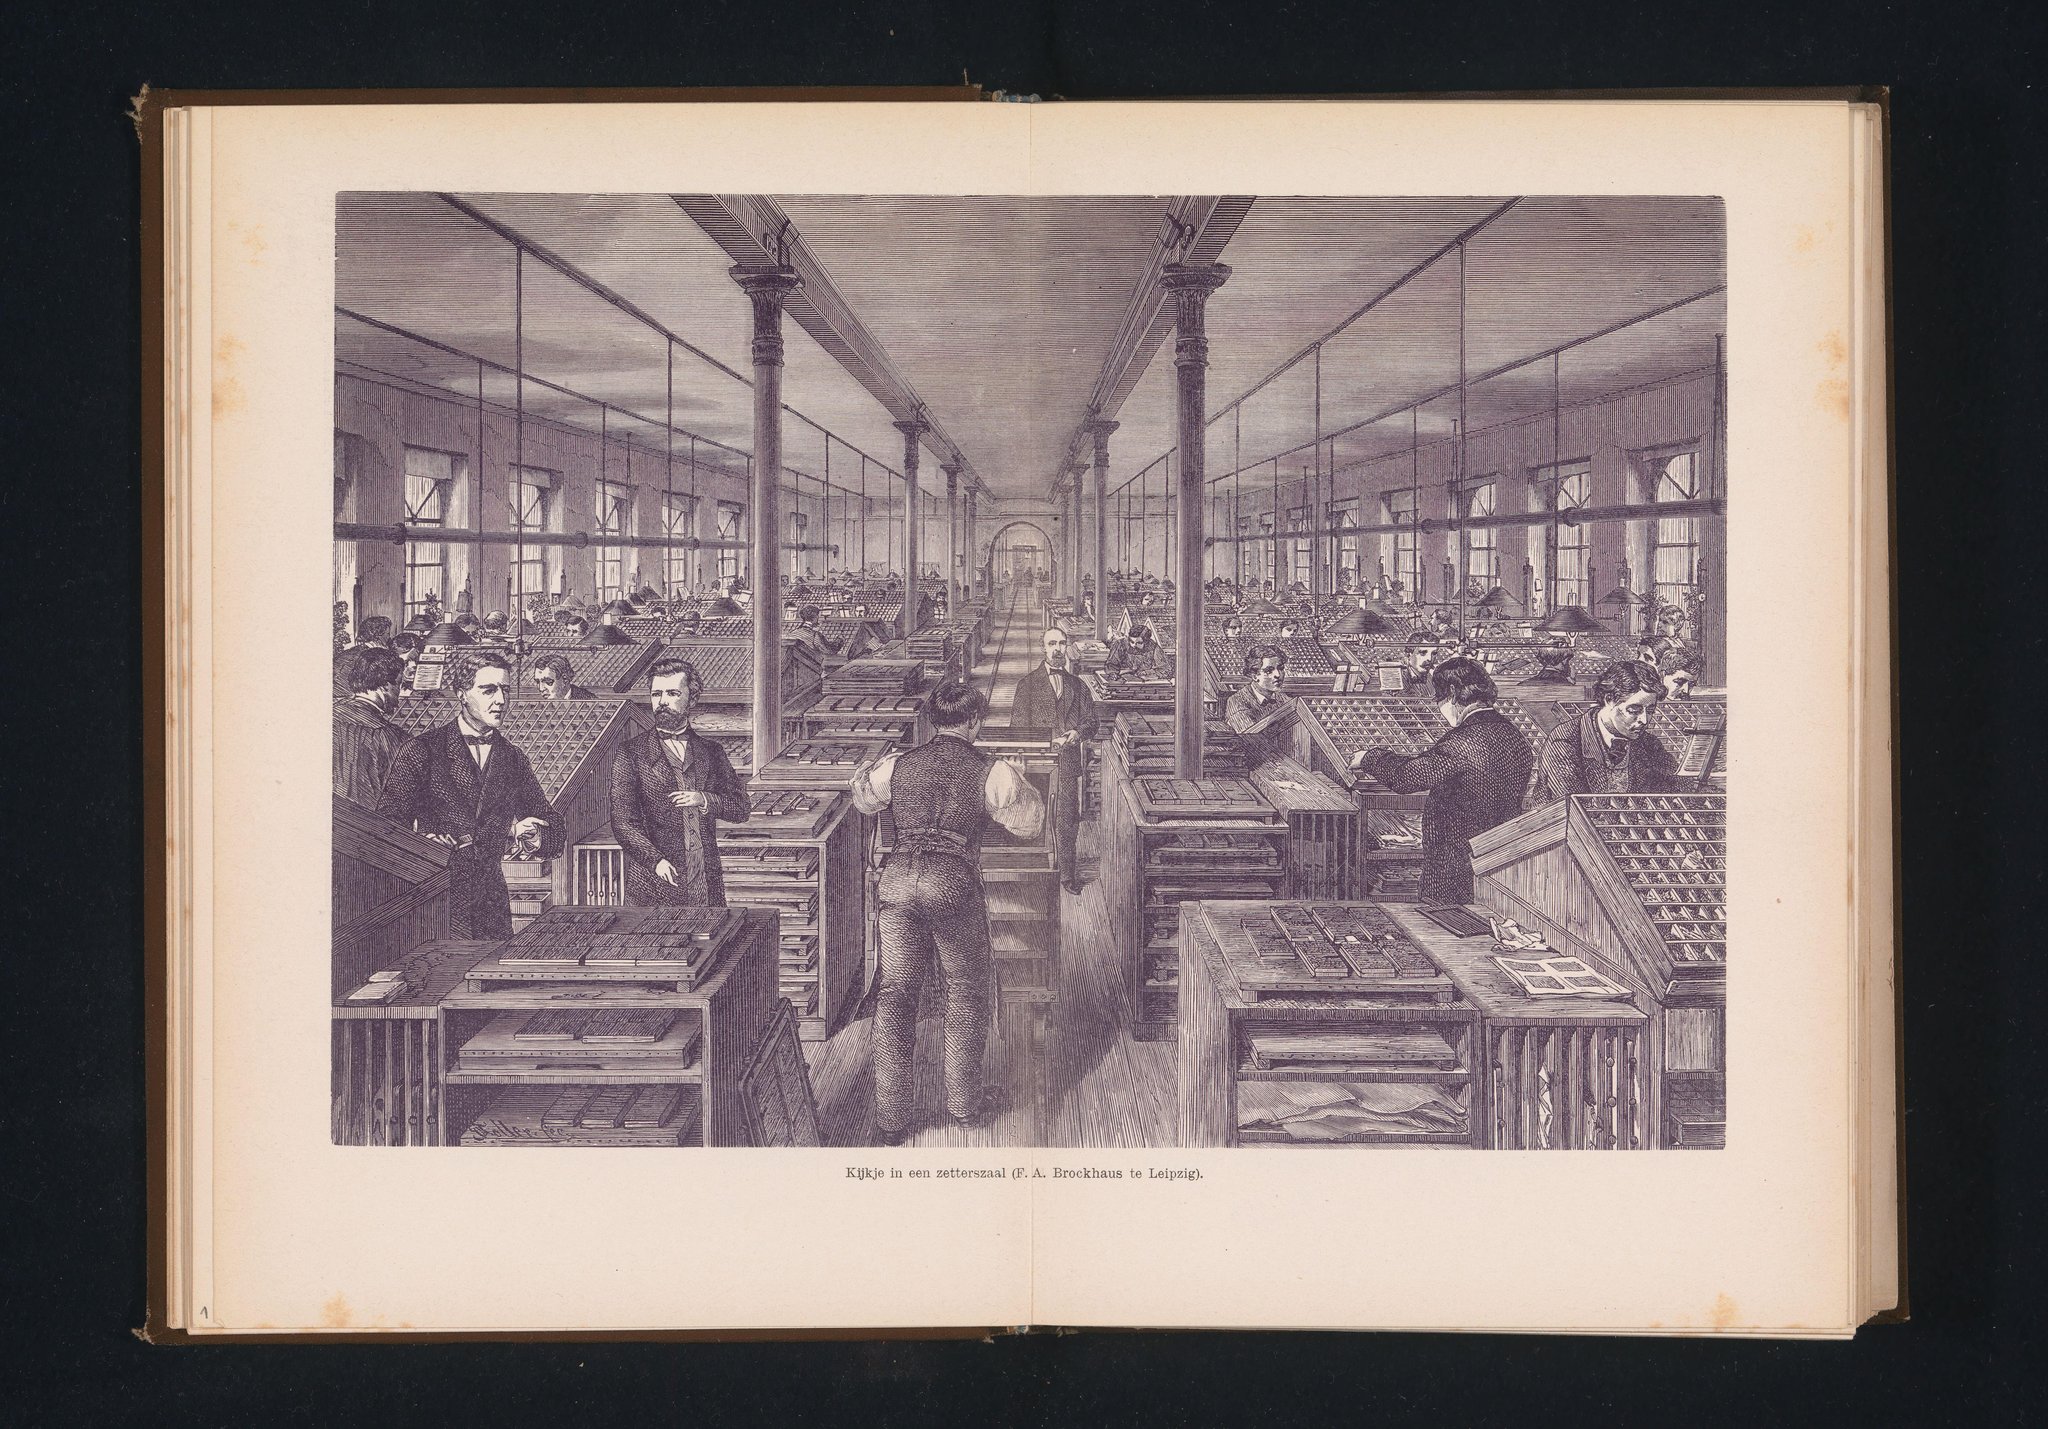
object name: reproduction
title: Kijkje in een zetterszaal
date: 1887-1892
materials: paper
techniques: printing block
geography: leipzig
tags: adult man, printing, printing office, tools, implements of printer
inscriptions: inscription: ‘J. [.]oller. fec.’